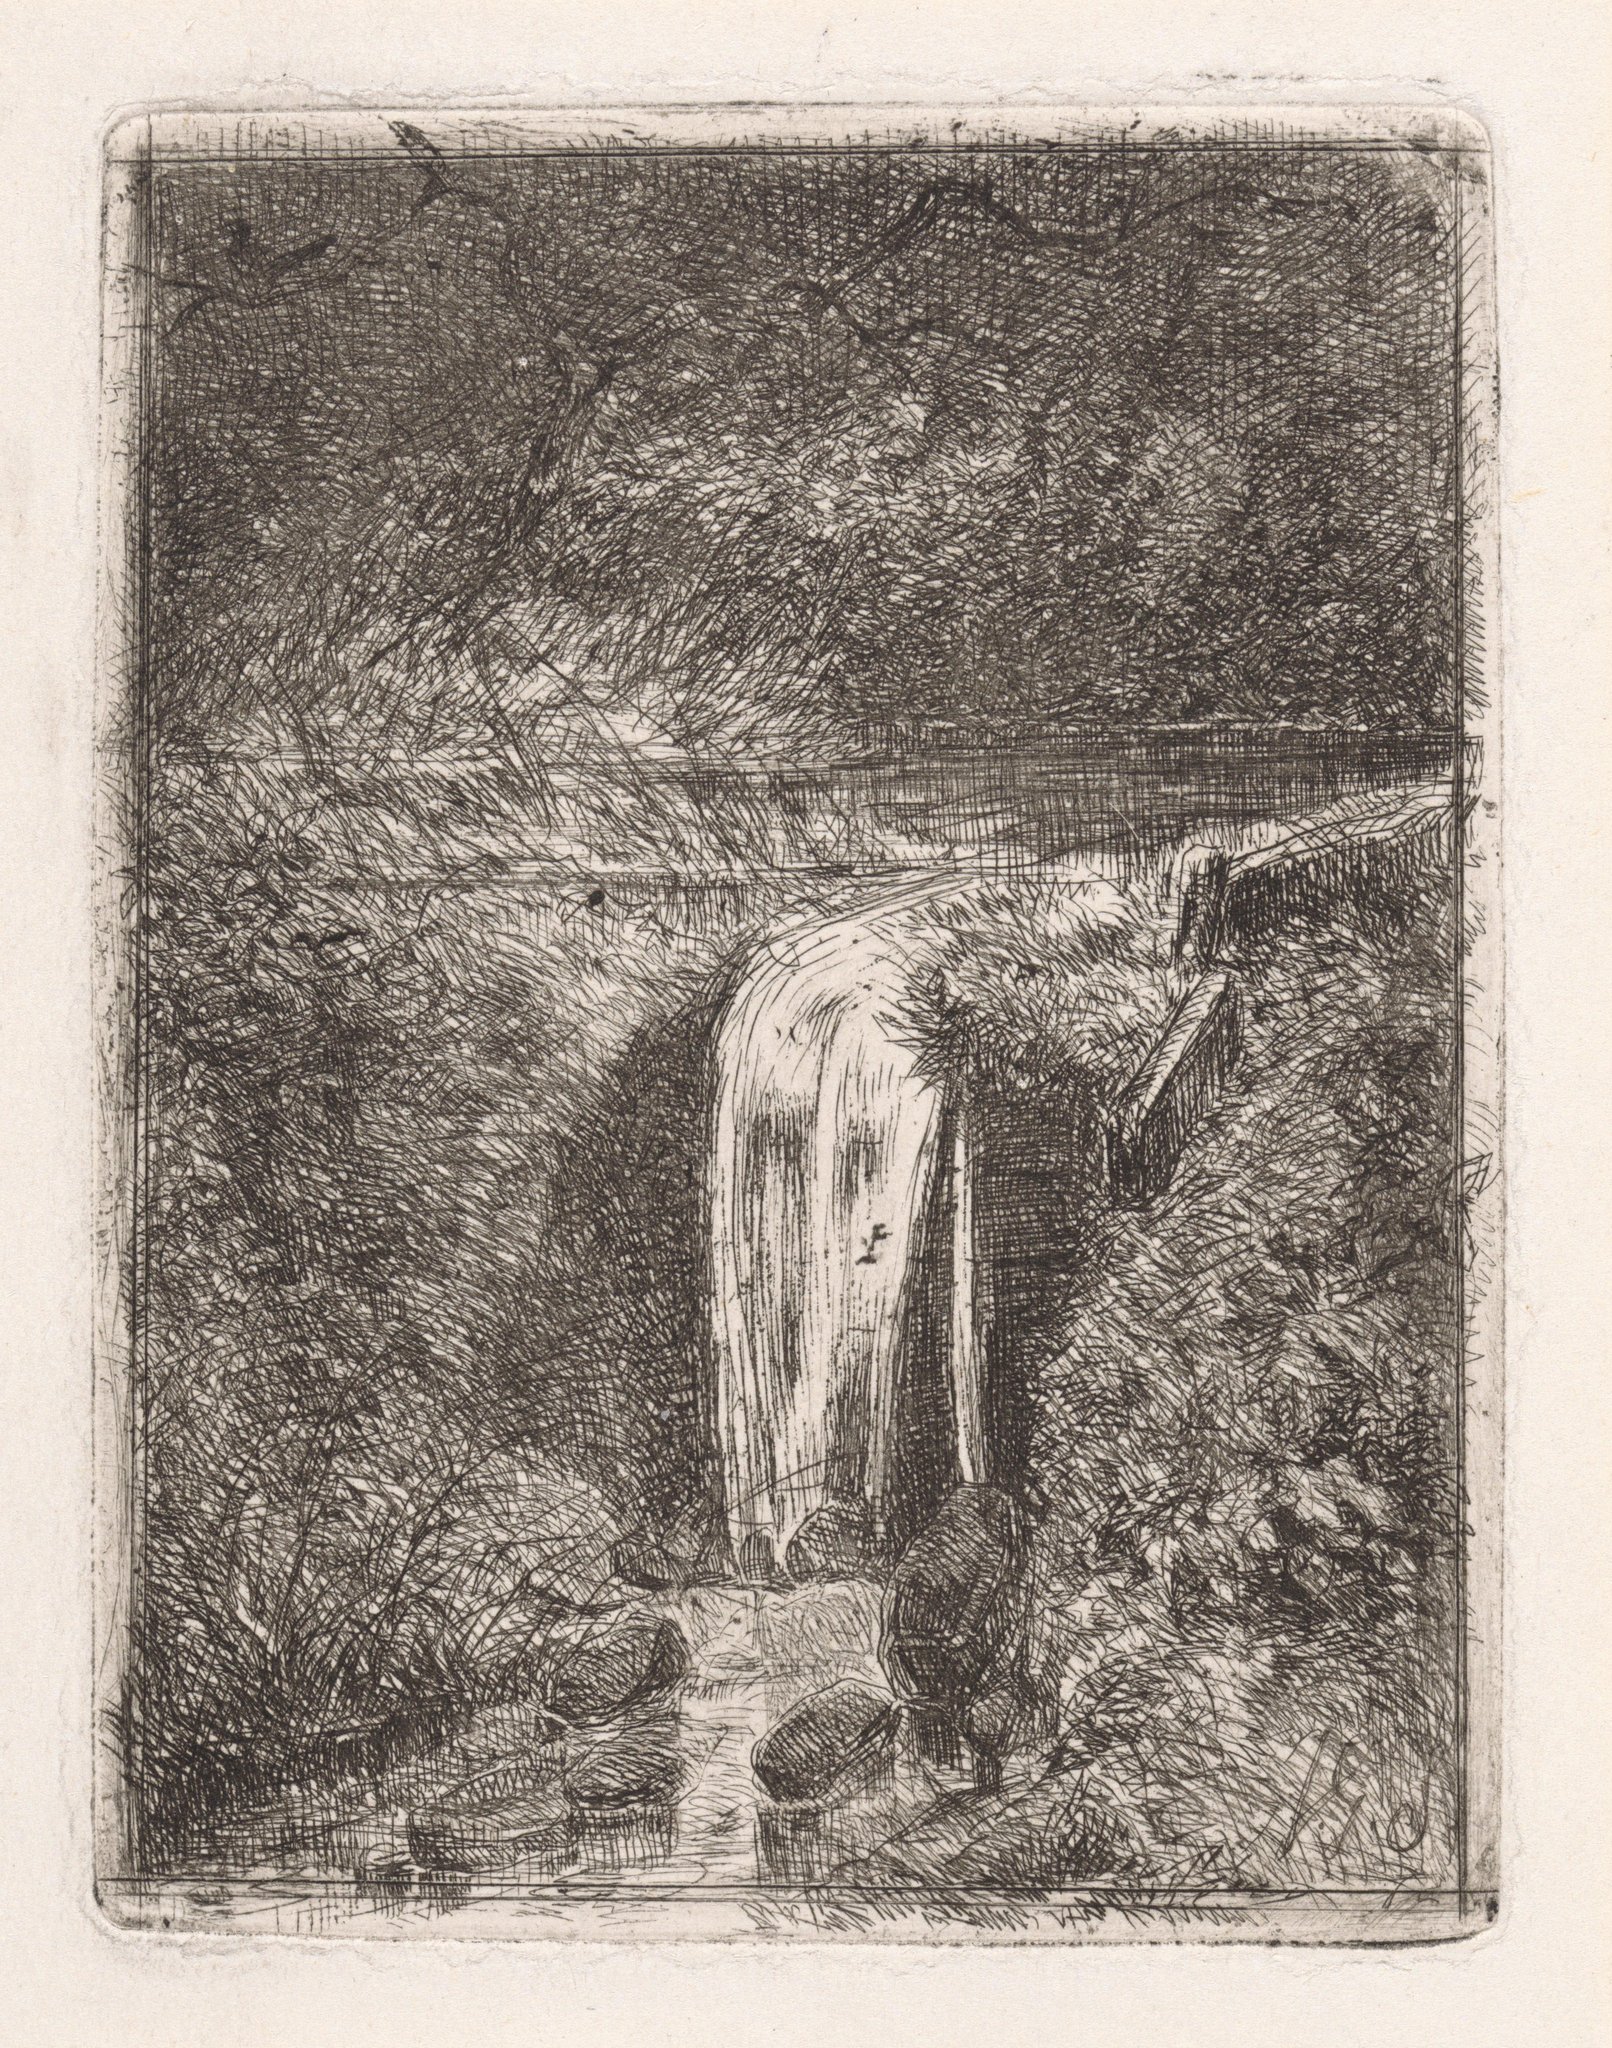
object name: print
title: Waterval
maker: jan gerard smits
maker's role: draughtsman, print maker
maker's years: 1823-1910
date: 1872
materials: paper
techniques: engraving, etching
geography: the hague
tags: waterfall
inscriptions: collector's mark: Lugt 2228